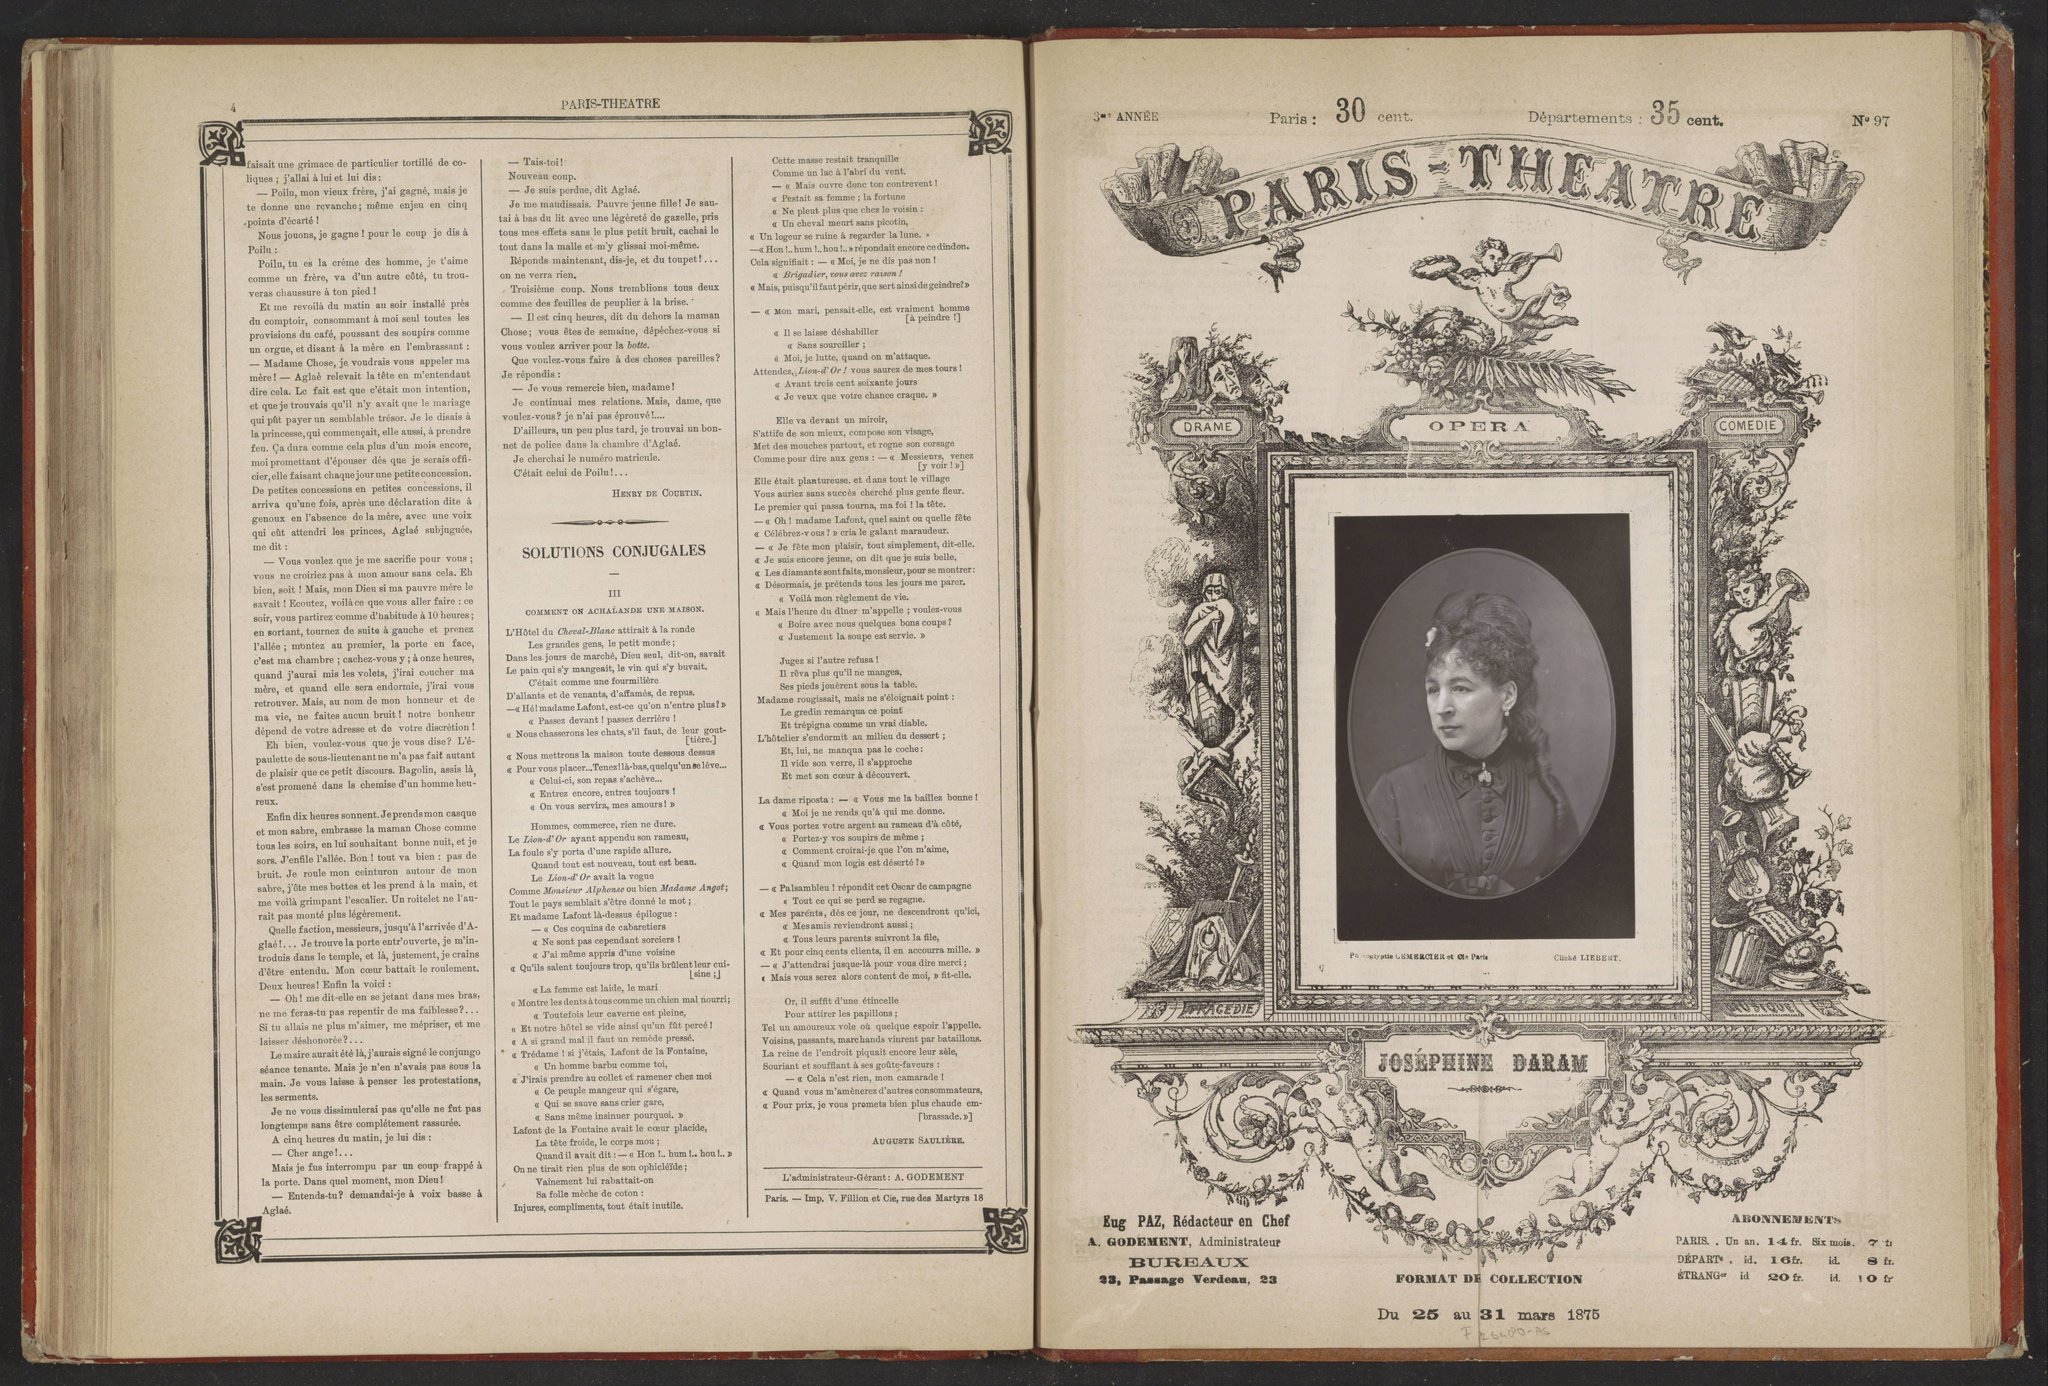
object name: photomechanical print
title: Portret van Joséphine Daram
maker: alphonse-justin liébert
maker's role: fotograaf, marinier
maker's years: 1827-1914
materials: paper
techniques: woodburytype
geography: paris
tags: portrait of opera-singer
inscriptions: inscription: ‘Du 25 au 31 mars 1875’, number: ‘No 97’